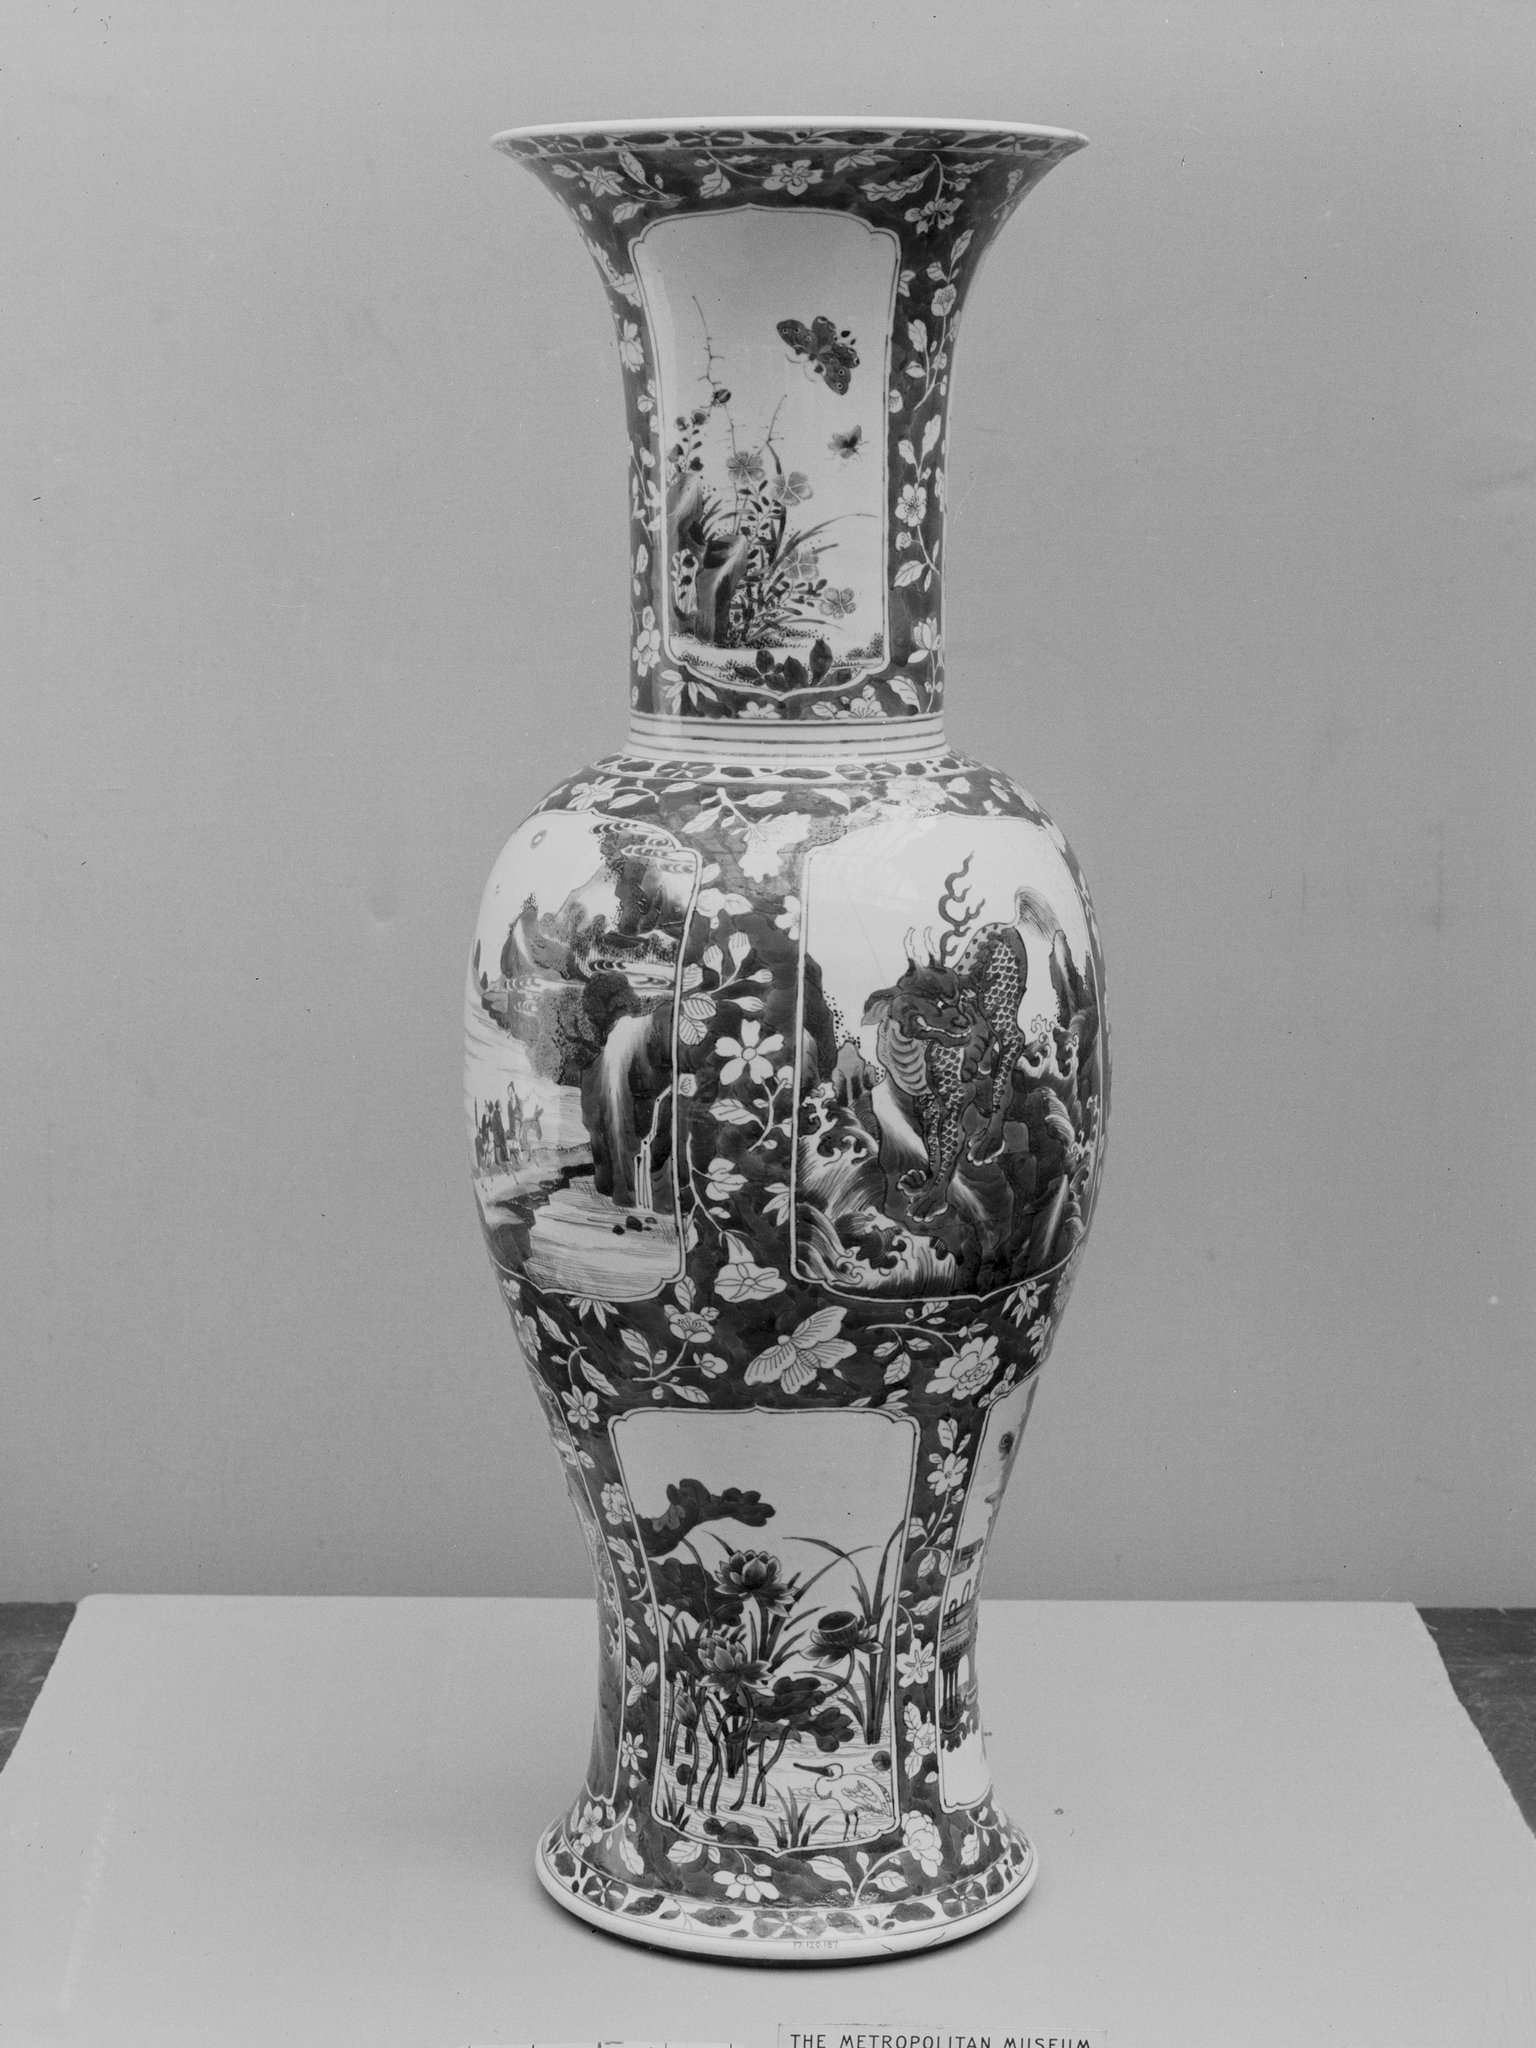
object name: vase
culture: chinese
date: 1662-1722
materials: porcelain